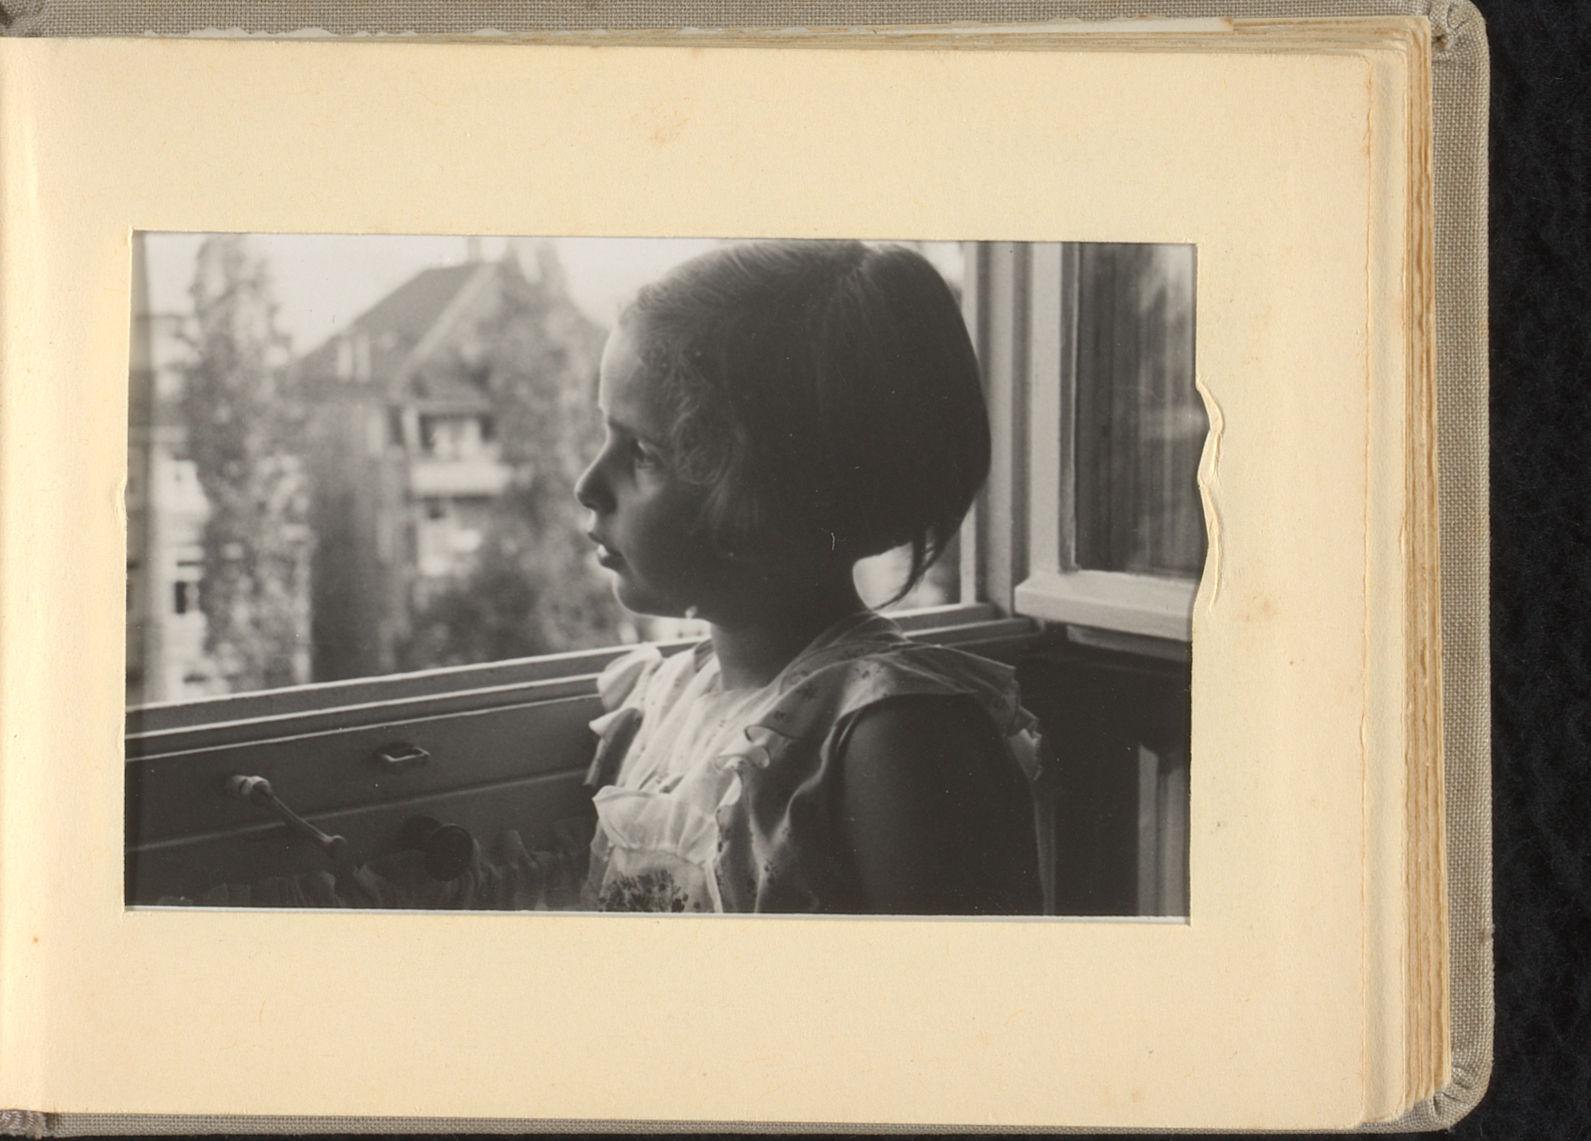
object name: album leaf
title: Isabel Wachenheimer kijkt uit het raam, 1931-1937, Stuttgart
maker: isabel wachenheimer-elon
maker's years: 1928-2010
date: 1931-1937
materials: paper, photographic support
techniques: gelatin silver print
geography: stuttgart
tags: leiden, isabel wachenheimer-elon, historical persons - bb - woman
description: Albumblad bevat een foto van Isabel Wachenheimer. Onderdeel van het fotoalbum met diverse foto's van de jeugd van Isabel Wachenheimer voor en tijdens de oorlog en diverse momenten van haar volwassen leven na de Tweede Wereldoorlog.